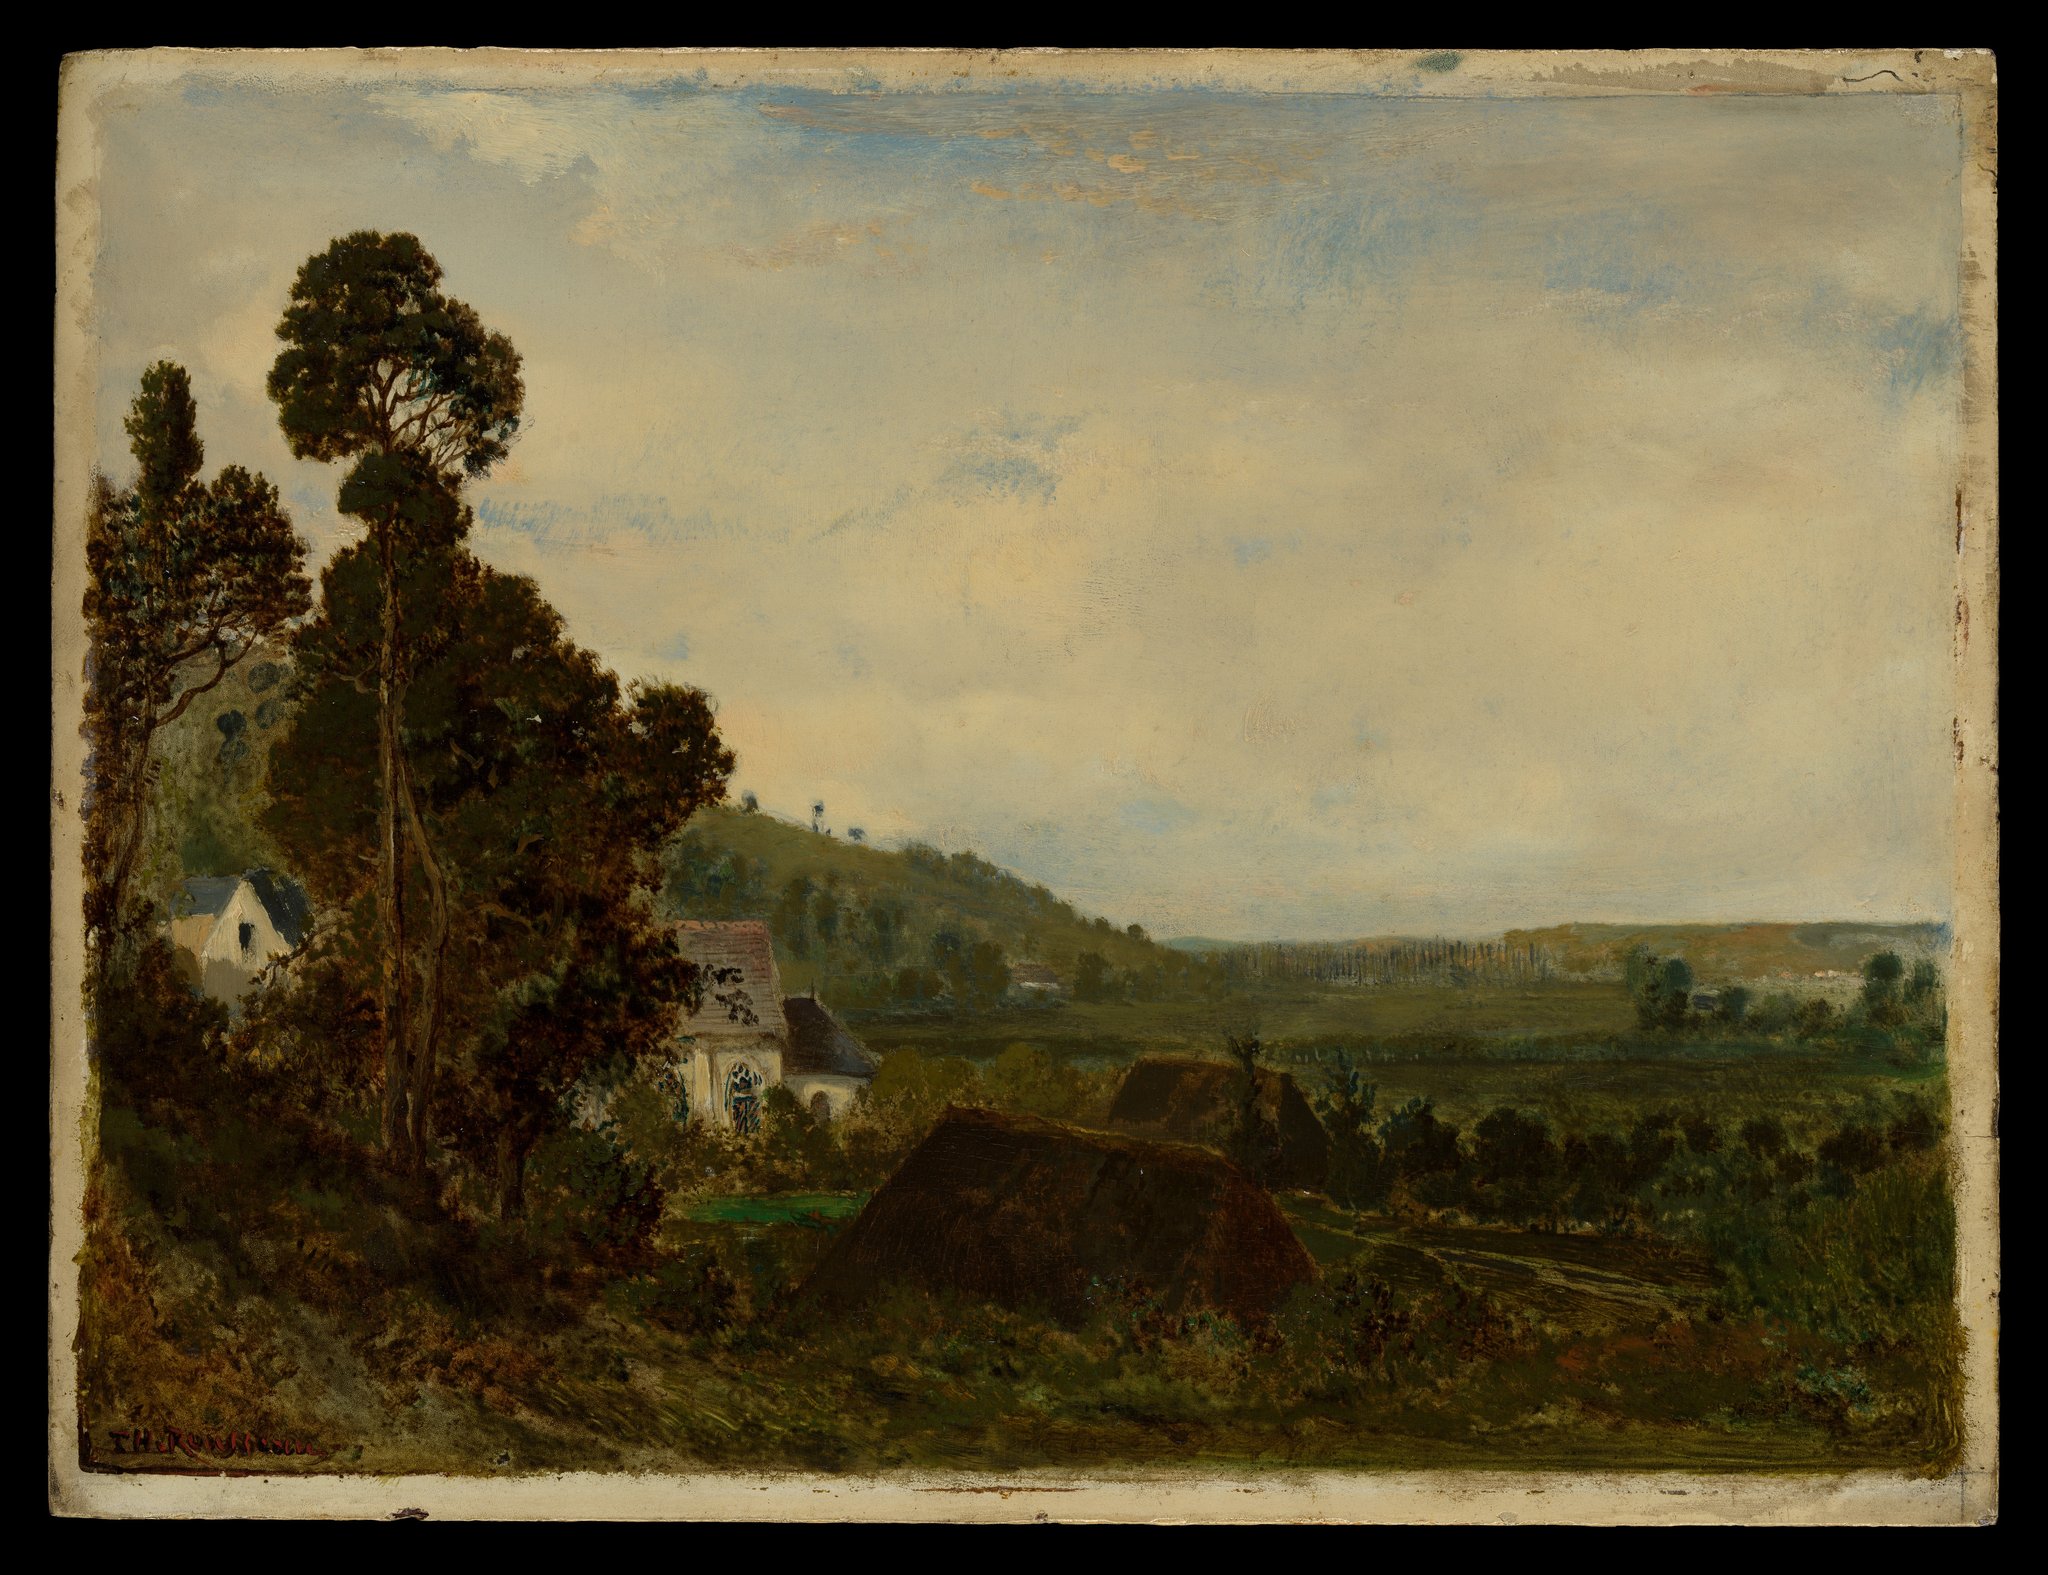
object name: painting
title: An Old Chapel in a Valley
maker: théodore rousseau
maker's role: artist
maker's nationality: french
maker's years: 1812-1867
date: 1835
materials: oil, wood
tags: landscapes